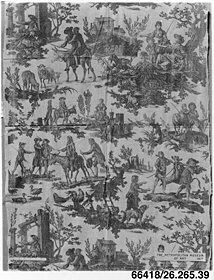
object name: furnishing textile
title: Le Meunier, son fils et l'âne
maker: jean-baptiste huet i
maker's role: designer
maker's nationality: french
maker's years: 1745-1811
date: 1806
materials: cotton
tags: birds,houses,men,dogs,horses,trees